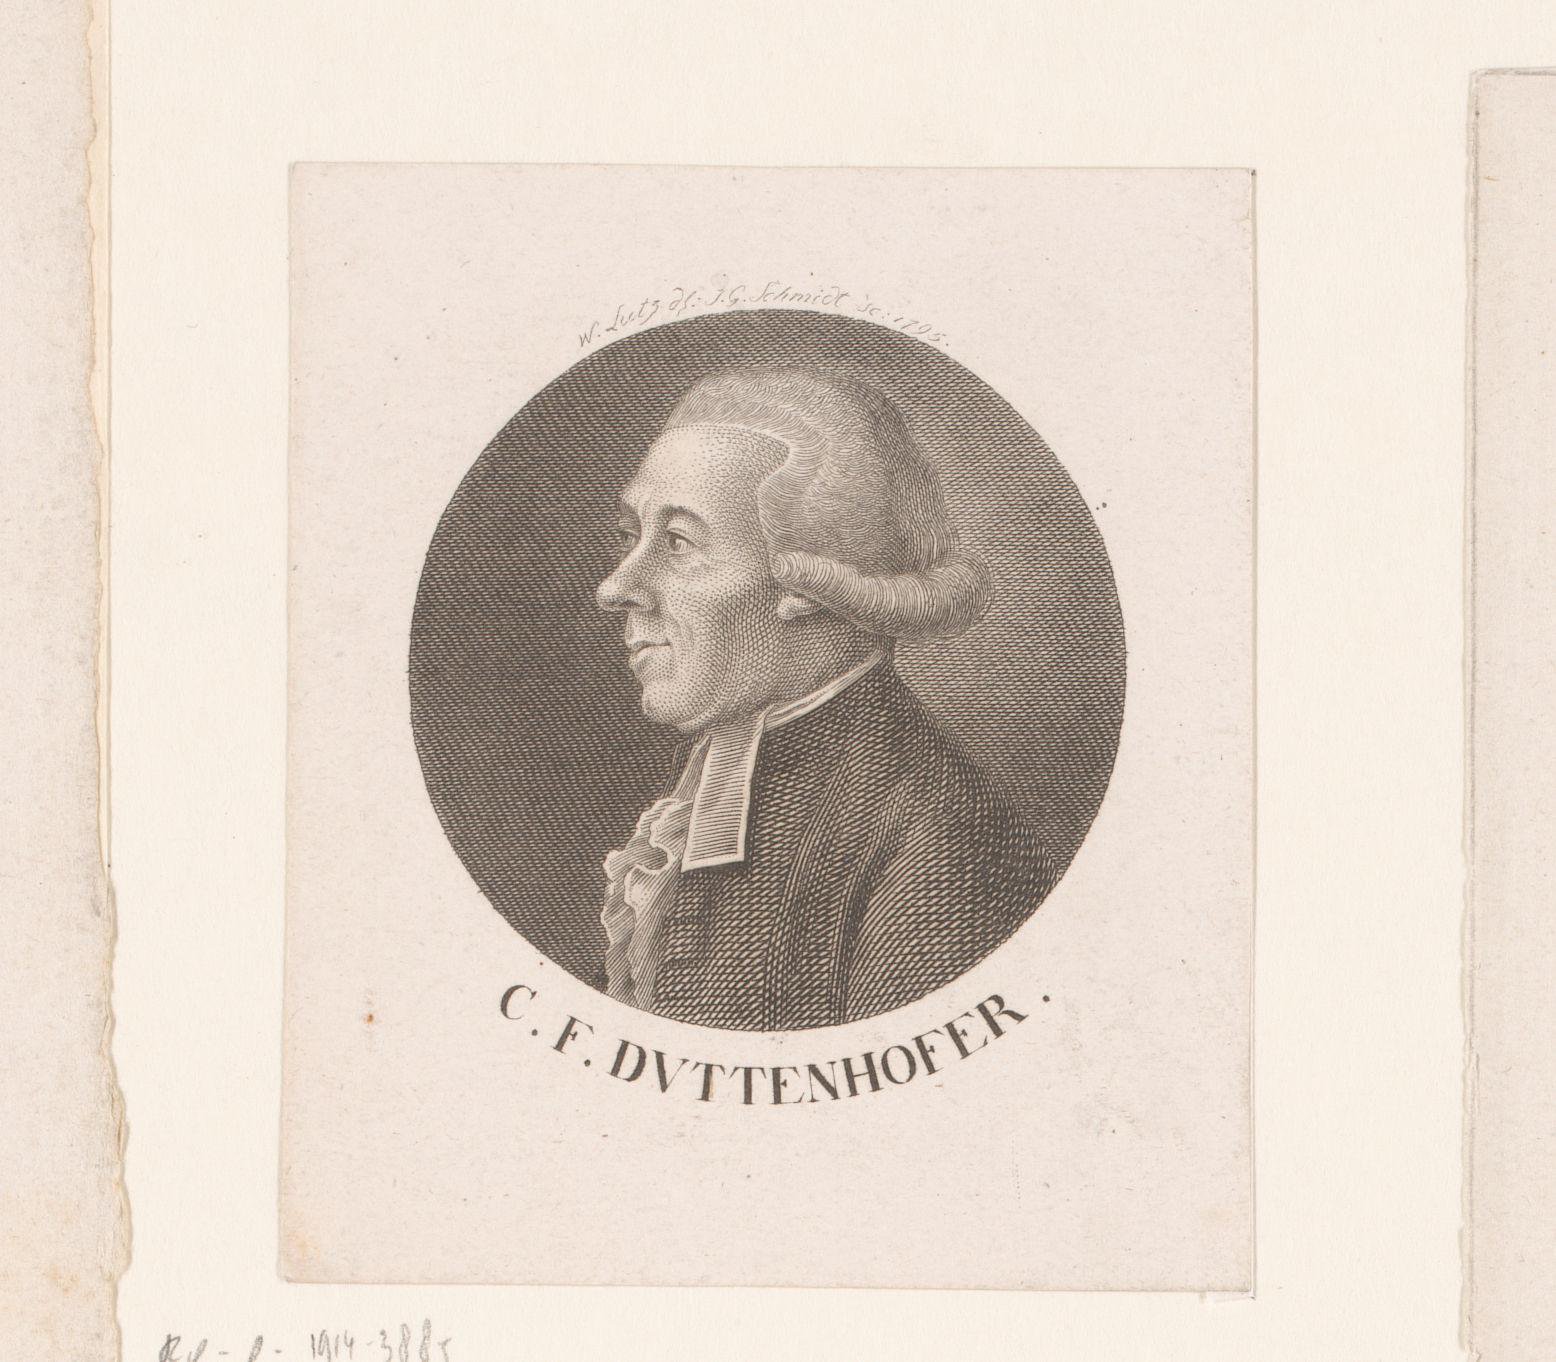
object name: print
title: Portret van Christian Friedrich Duttenhofer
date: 1795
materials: paper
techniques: engraving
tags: historical persons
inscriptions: collector's mark: Lugt 2228